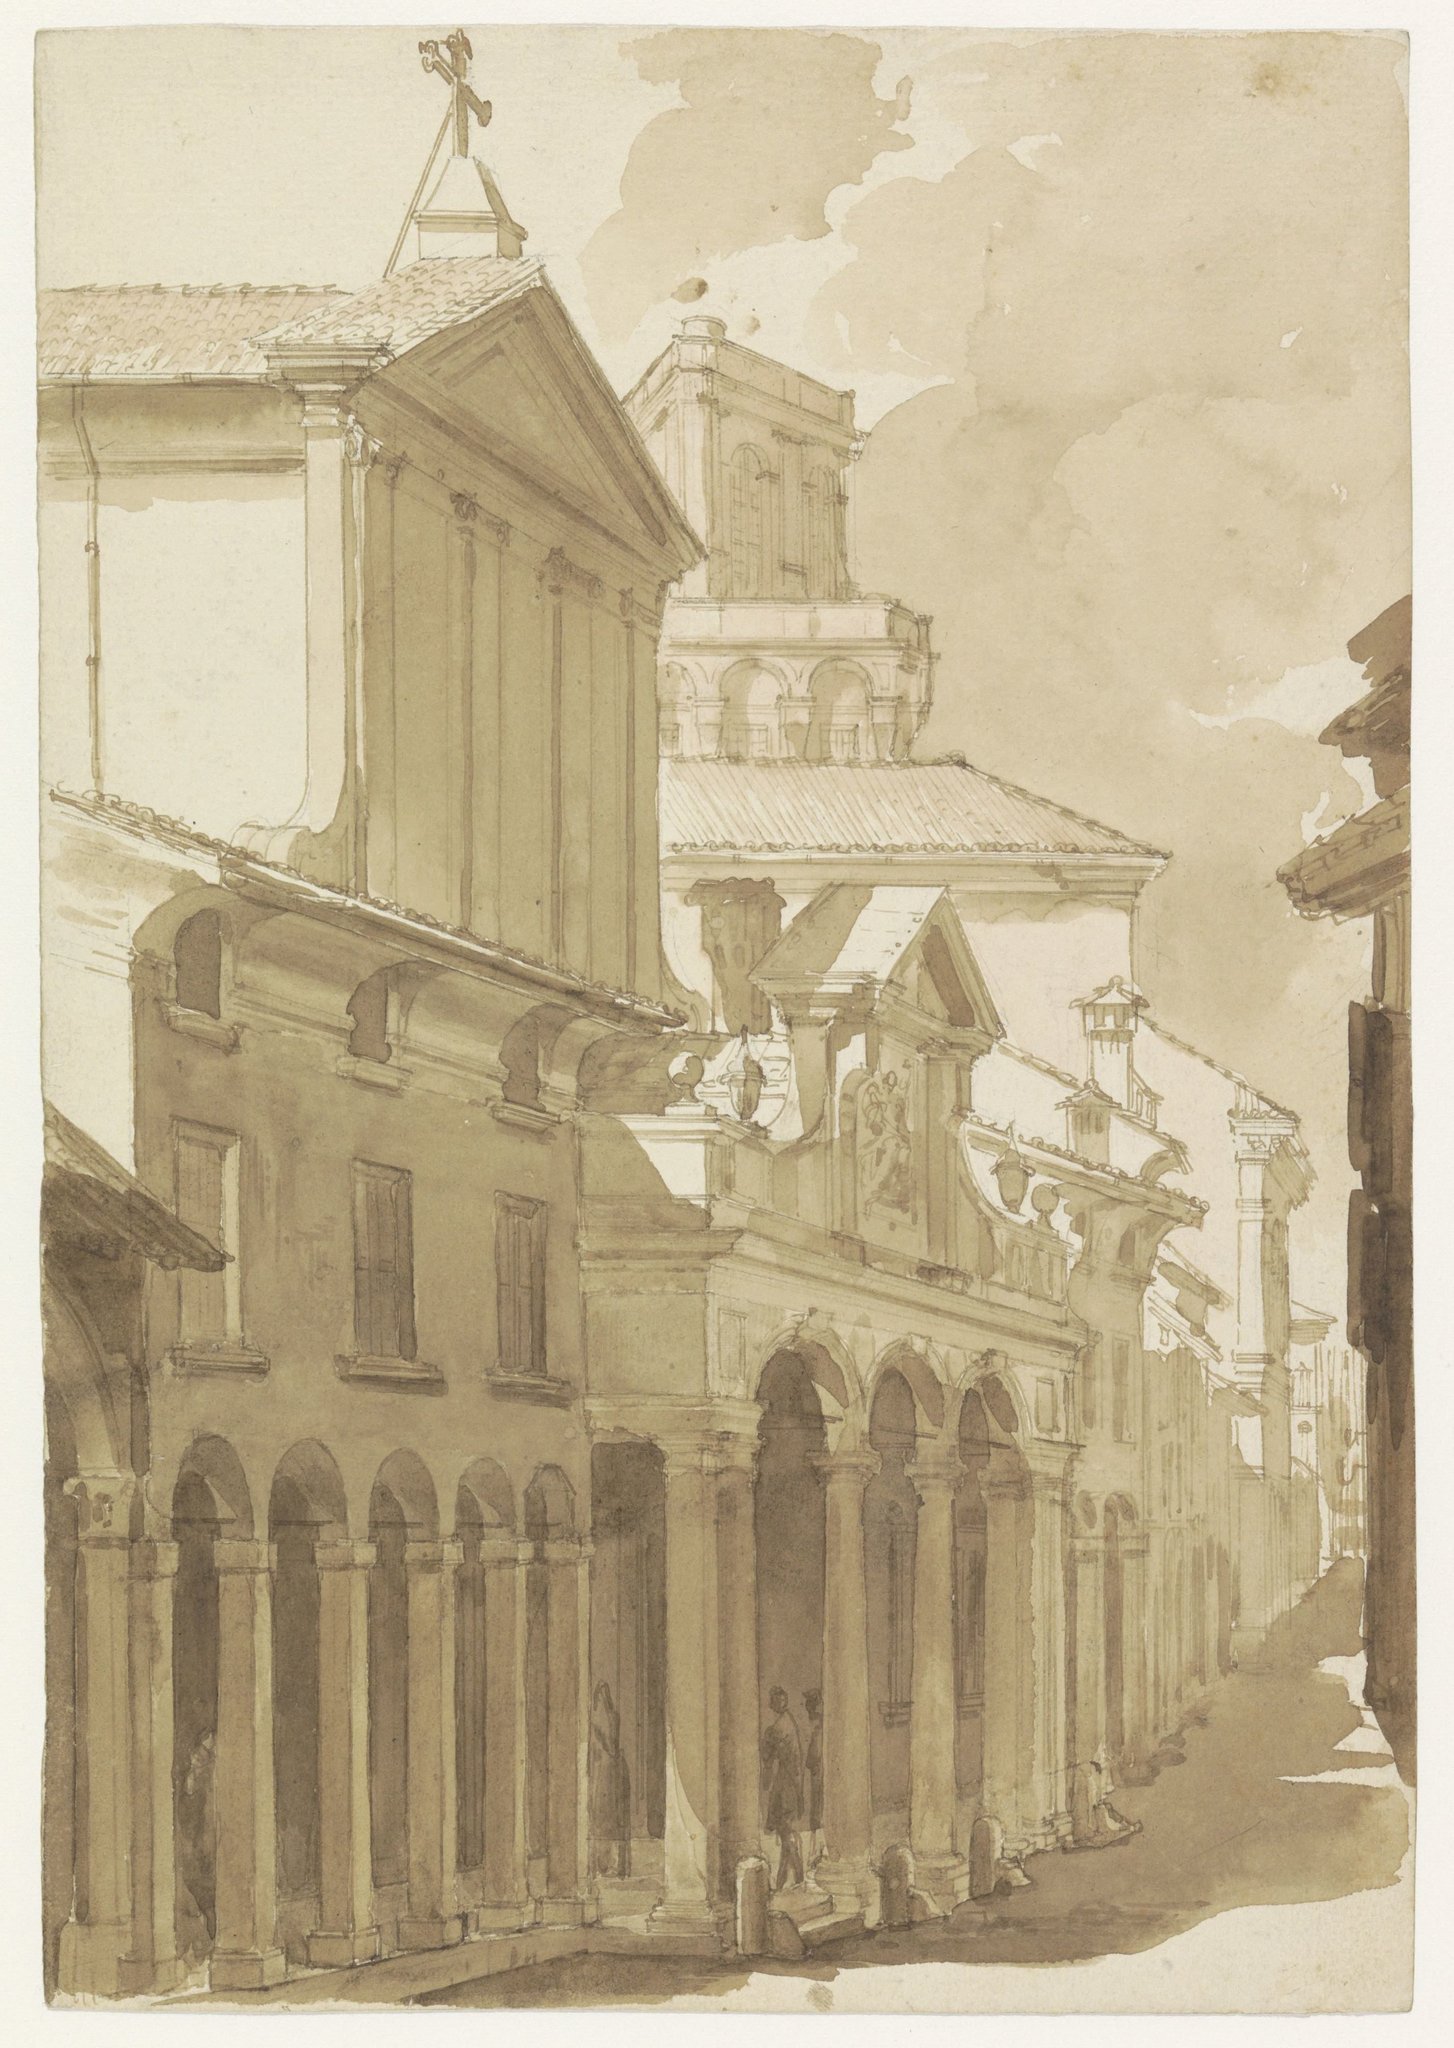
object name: drawing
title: Gezicht op de Magdalena-kerk in de Strada San Donato te Bologna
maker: gaetano gandolfi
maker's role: draughtsman, painter, print maker, sculptor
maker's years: 1734-1802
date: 1767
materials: chalk, graphite, ink, paper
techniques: brush, pen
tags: church (exterior), street, italy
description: Gezicht uit het huis van de schilder op de Magdalena-kerk in de Strada San Donato te Bologna.